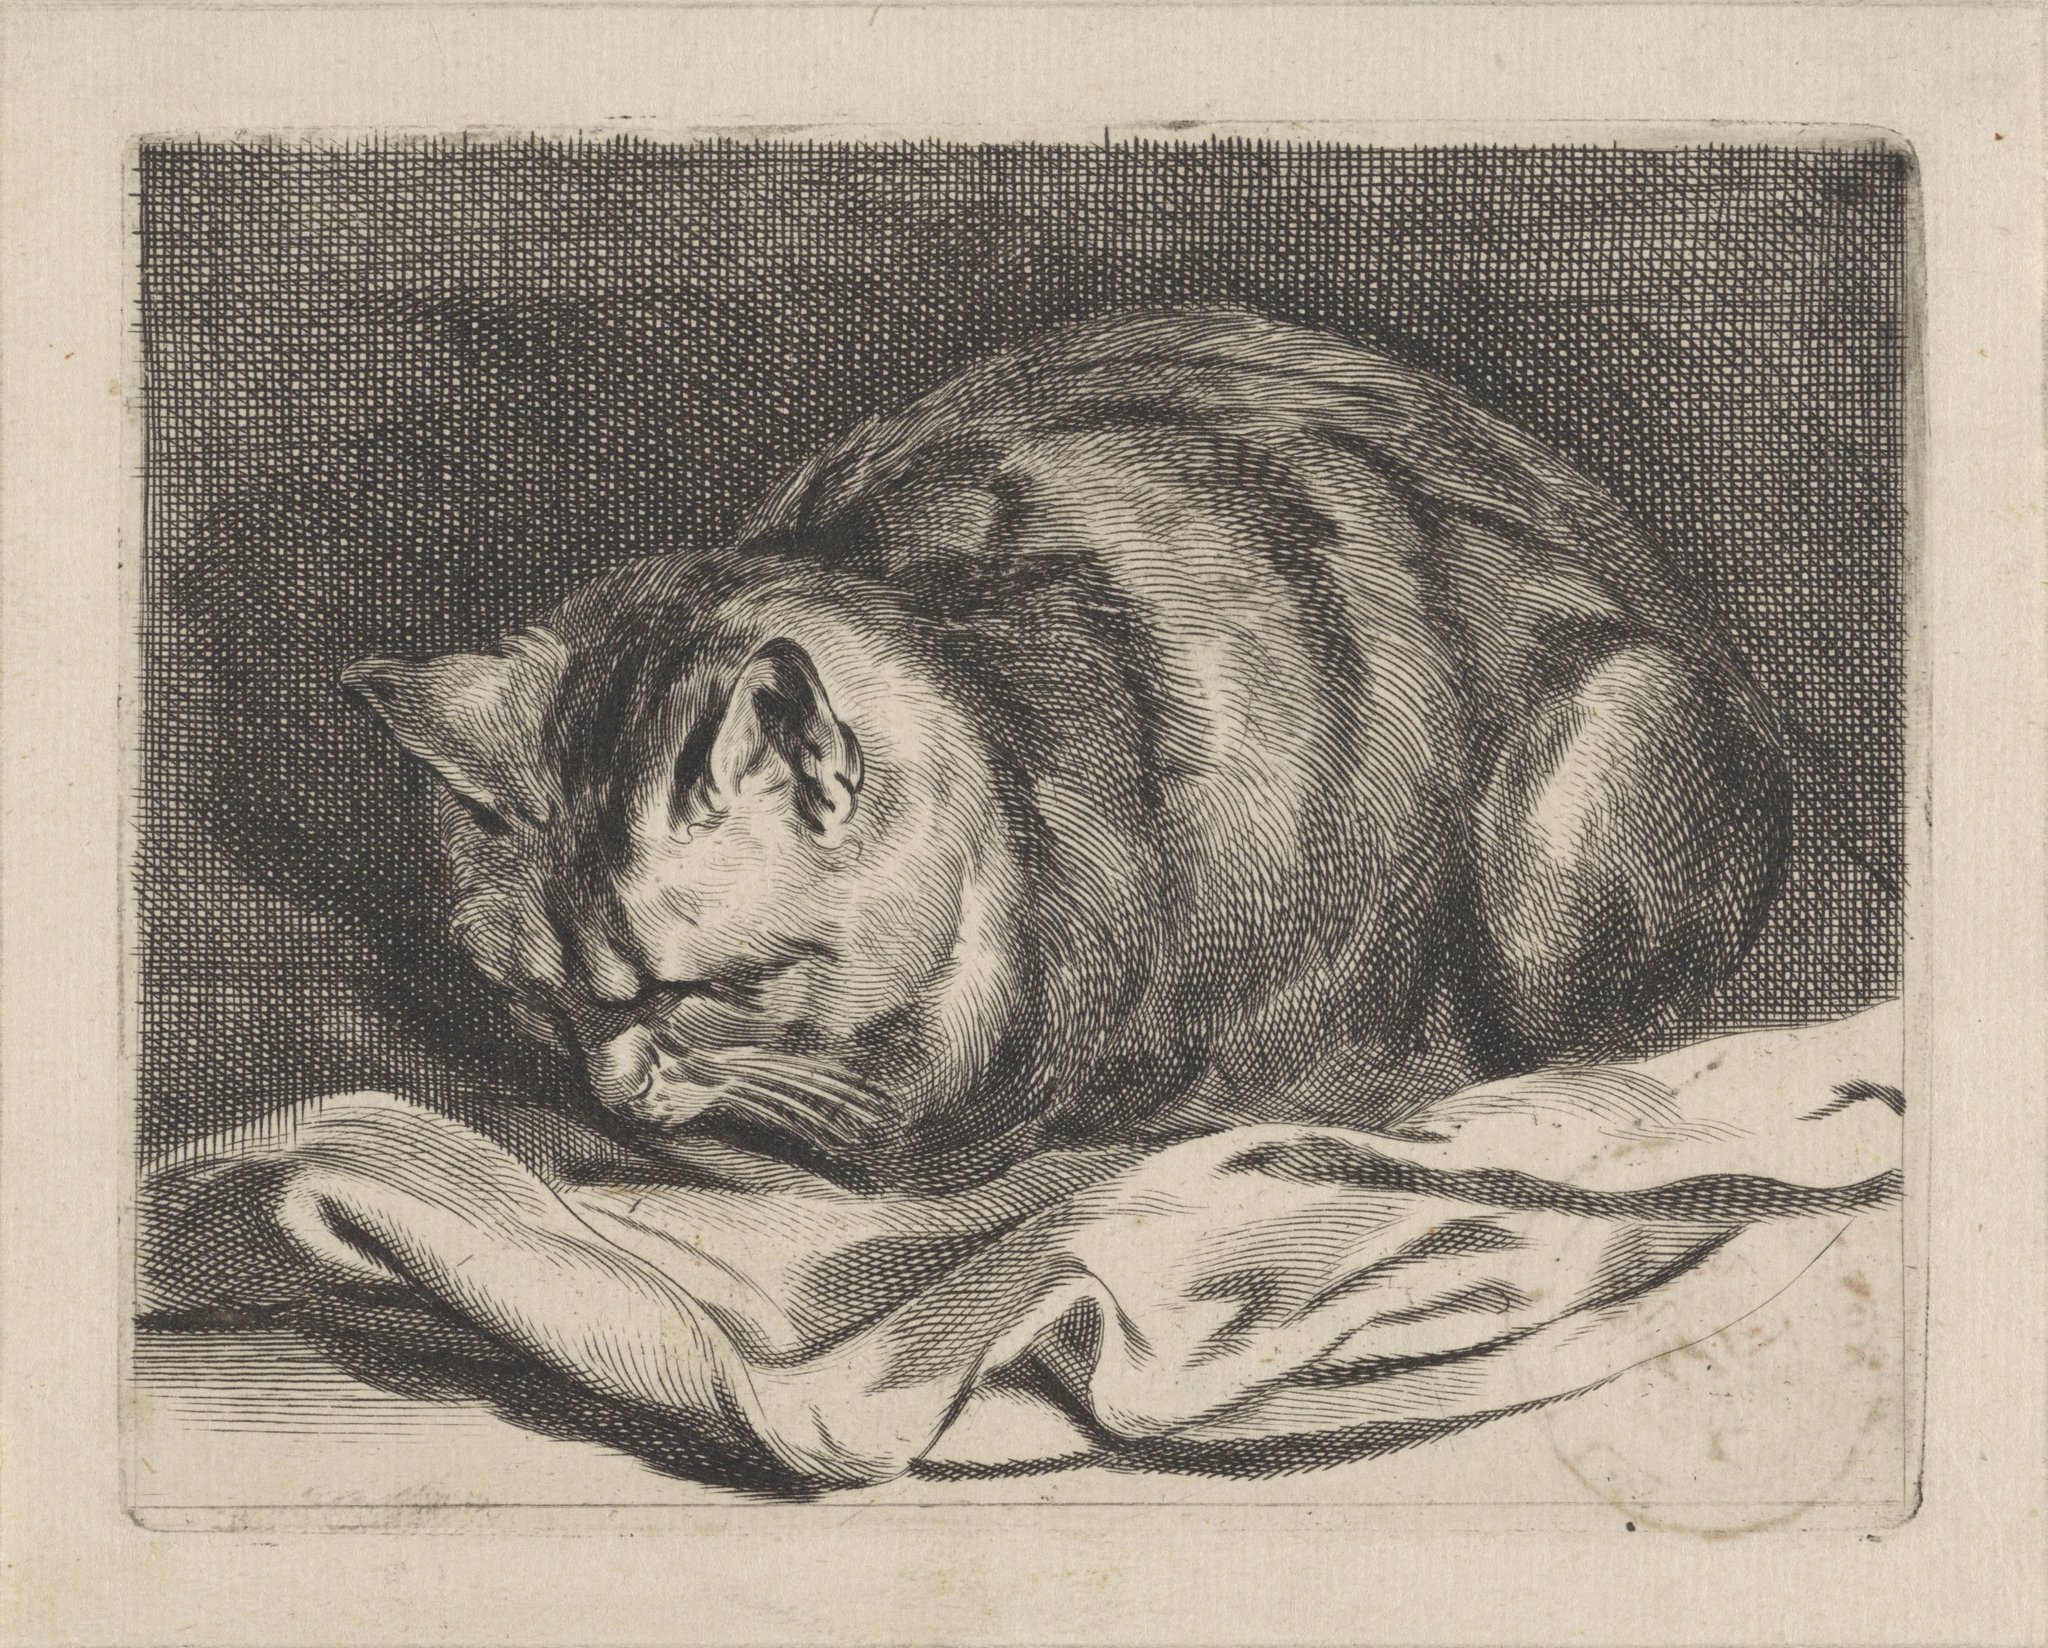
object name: print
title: Kleine kat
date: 1638-1658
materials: paper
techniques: engraving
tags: cat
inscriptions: collector's mark: Lugt 240